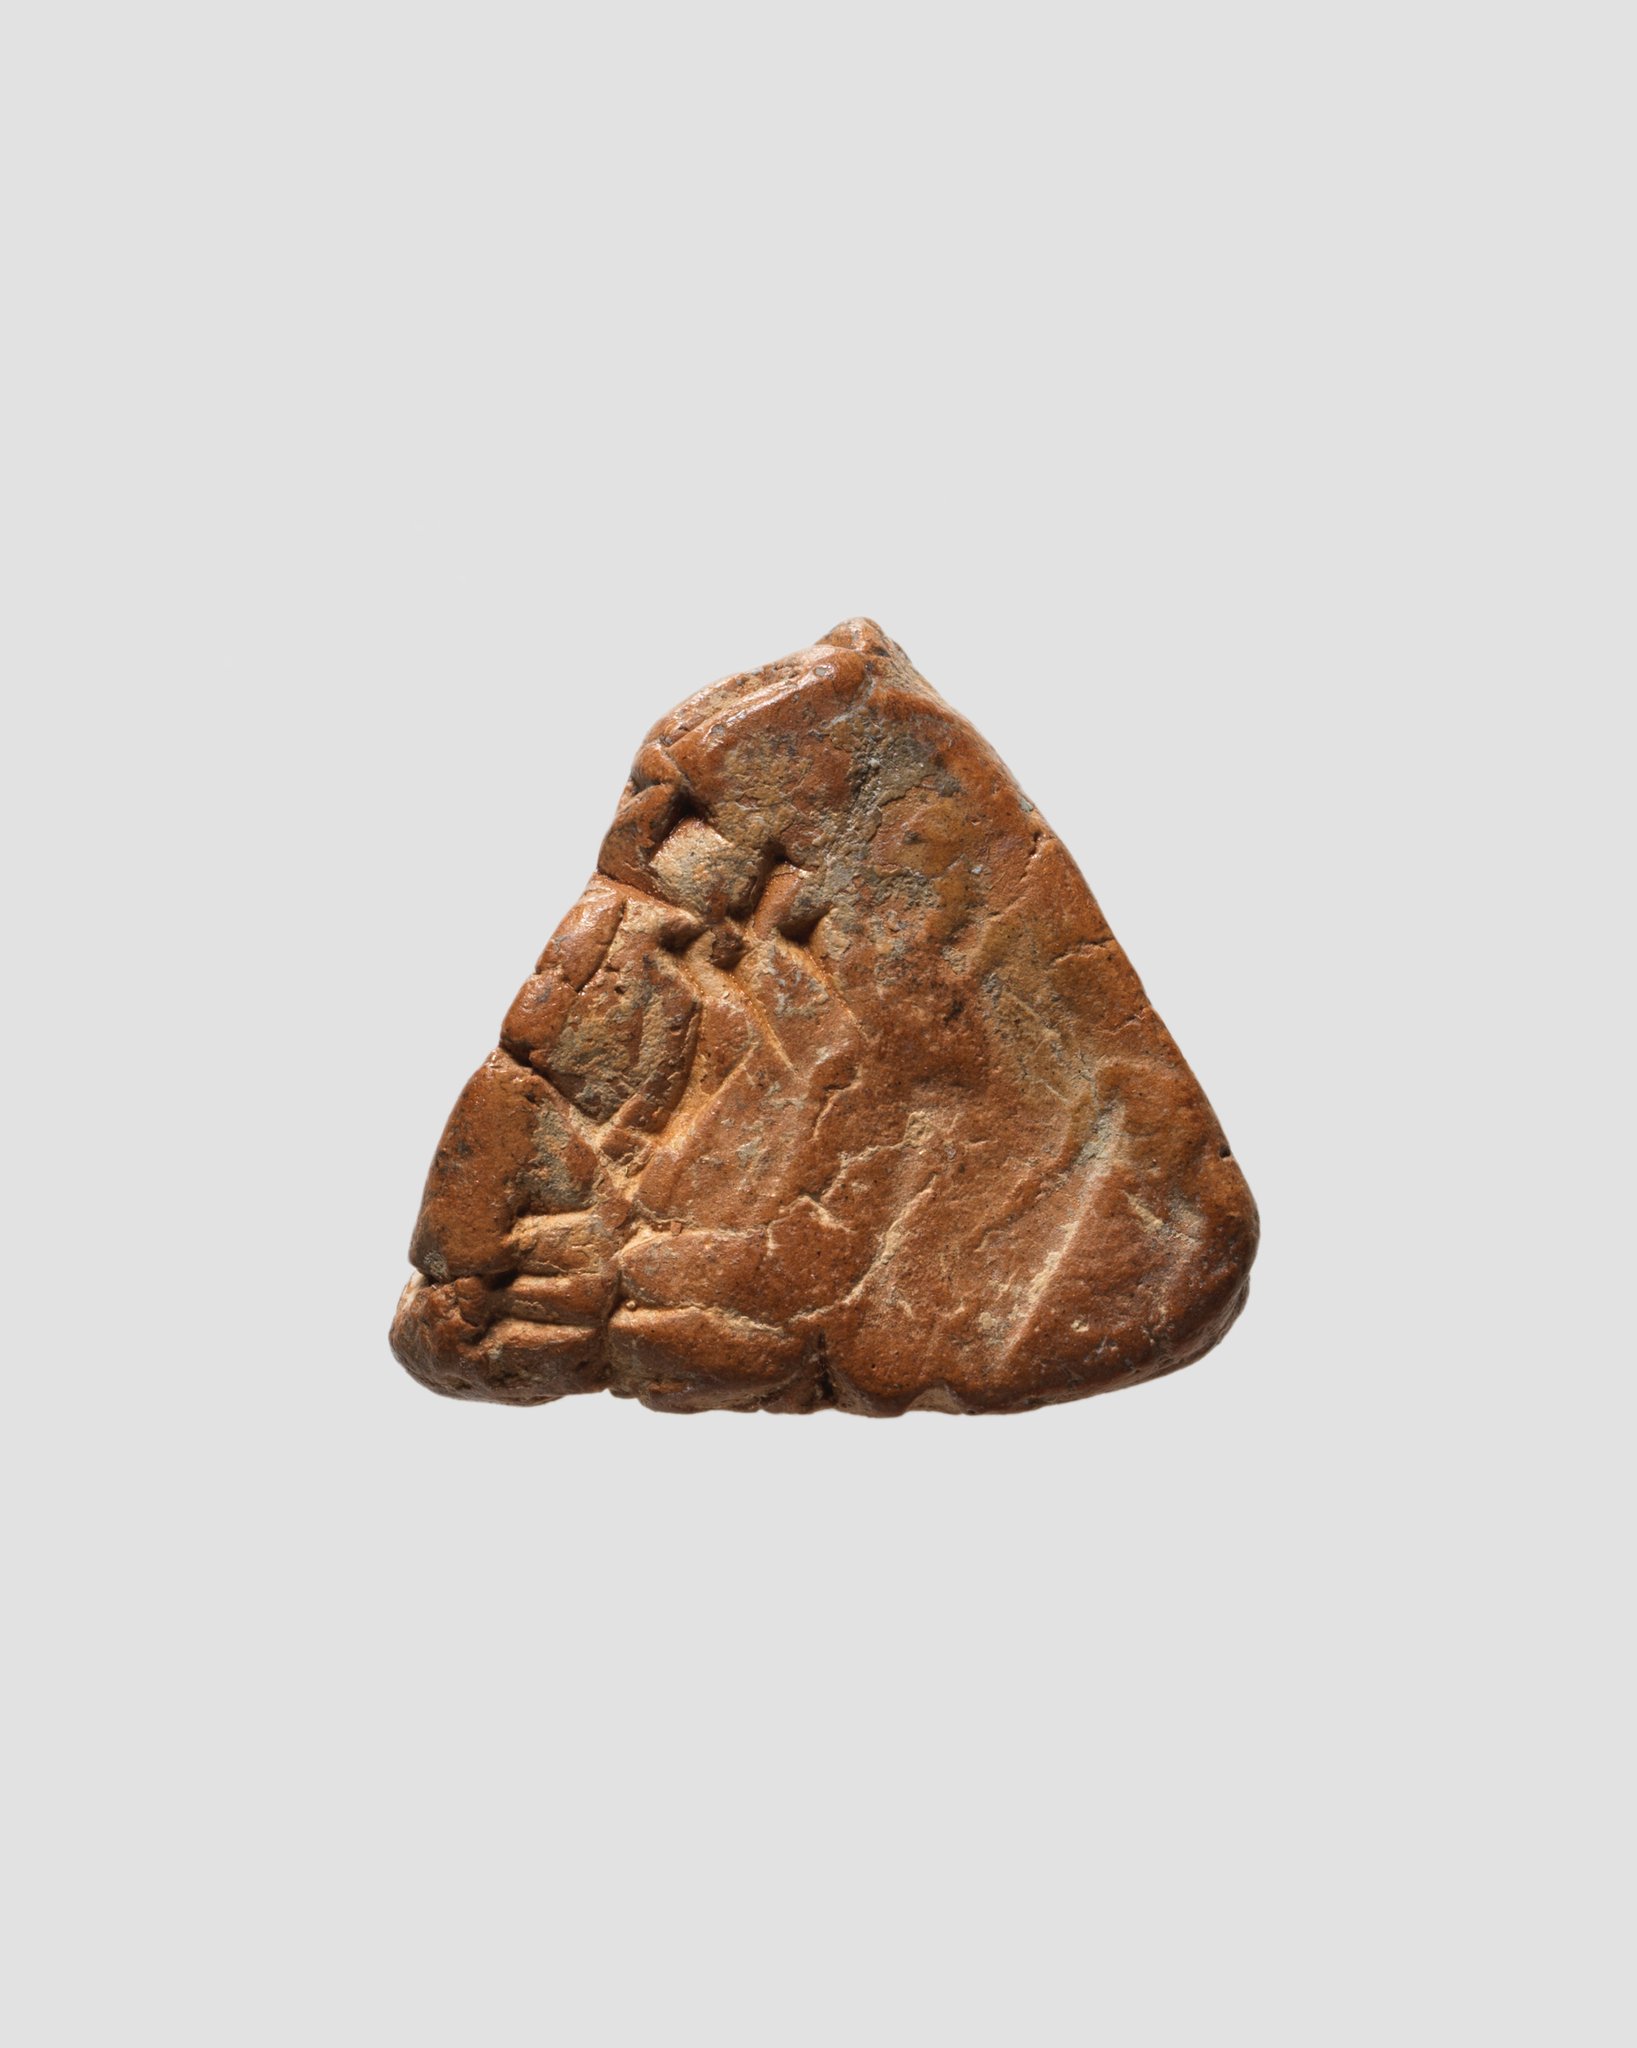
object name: cuneiform tablet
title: Cuneiform tablet impressed with cylinder seal: docket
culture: babylonian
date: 1745 BCE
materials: clay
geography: mesopotamia